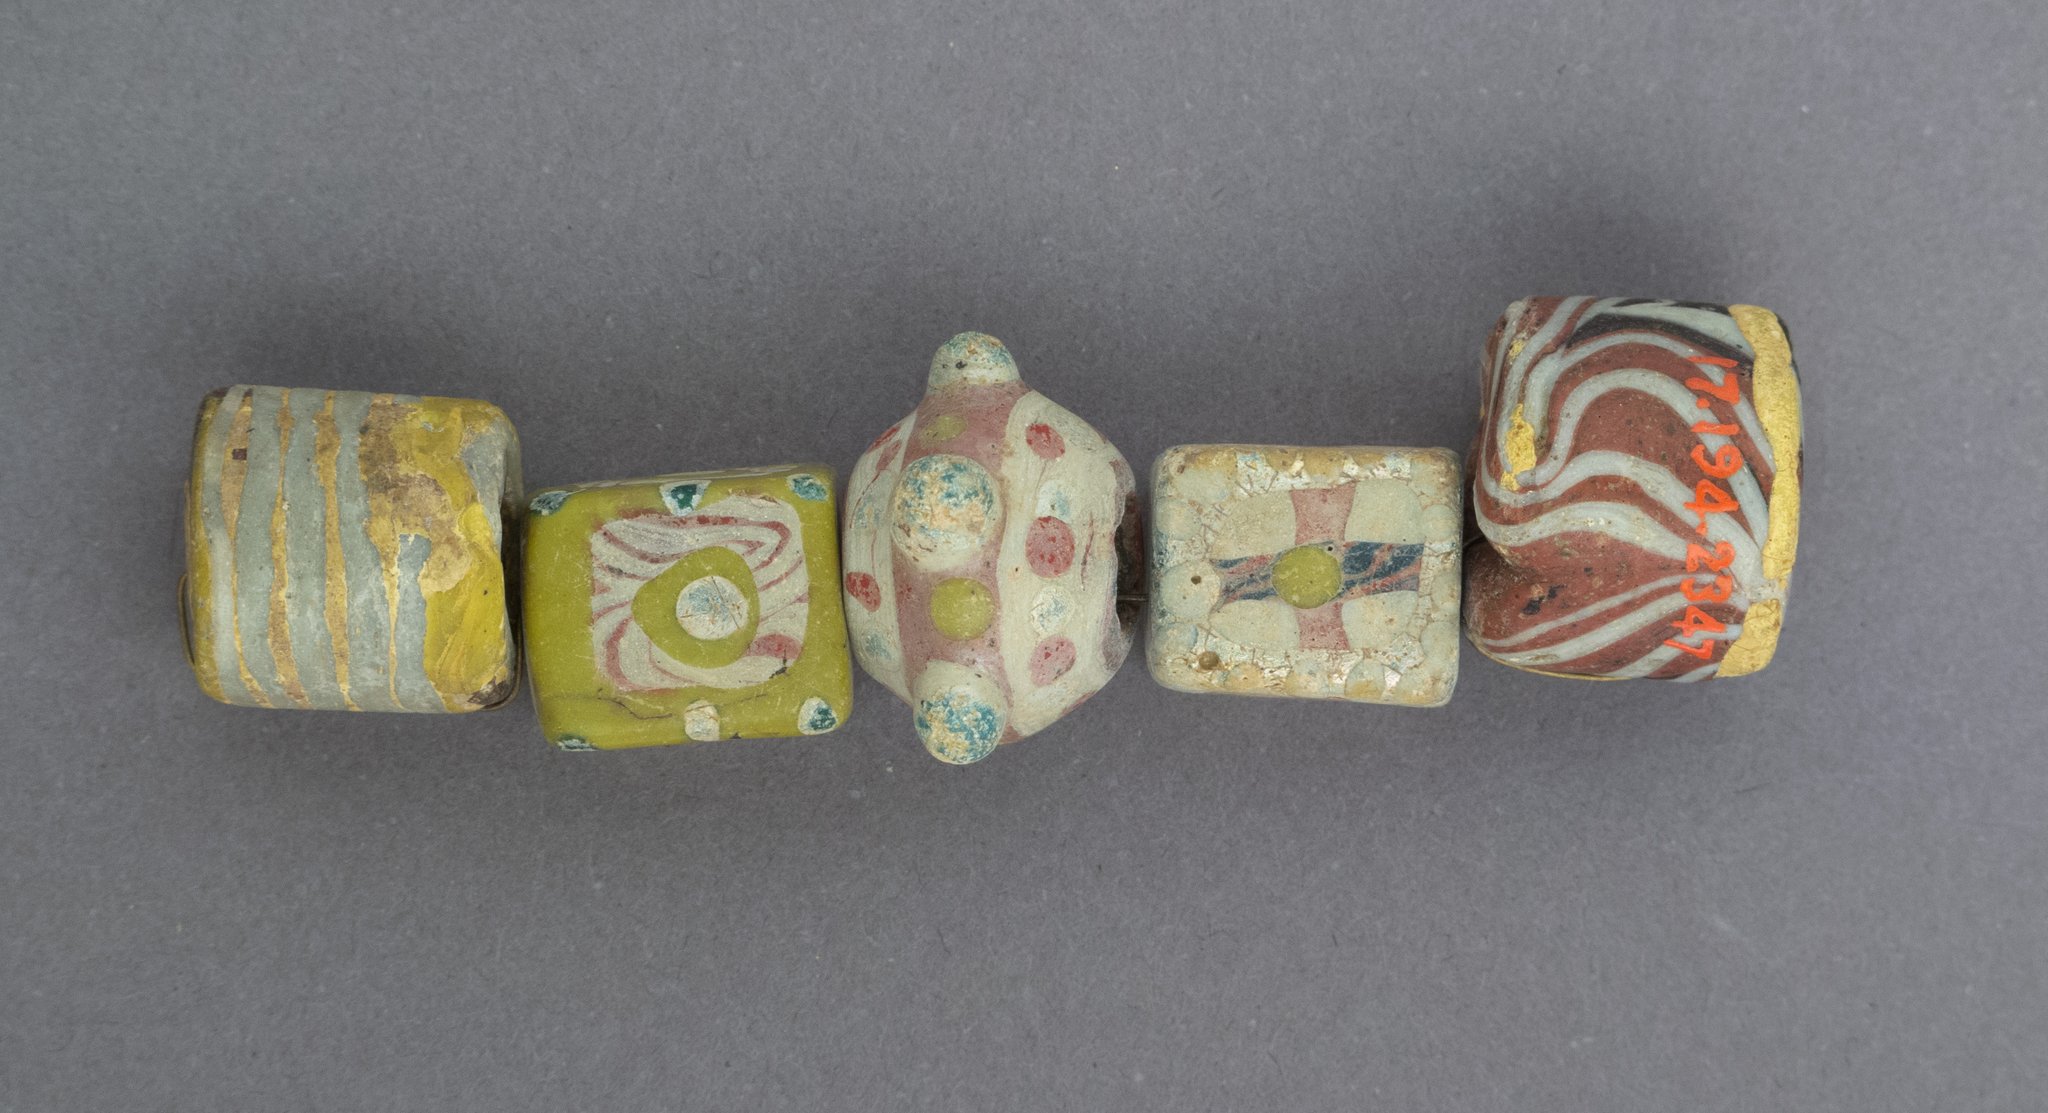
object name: bead, 5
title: Beads, 5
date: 7000 BCE-330 CE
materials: glass